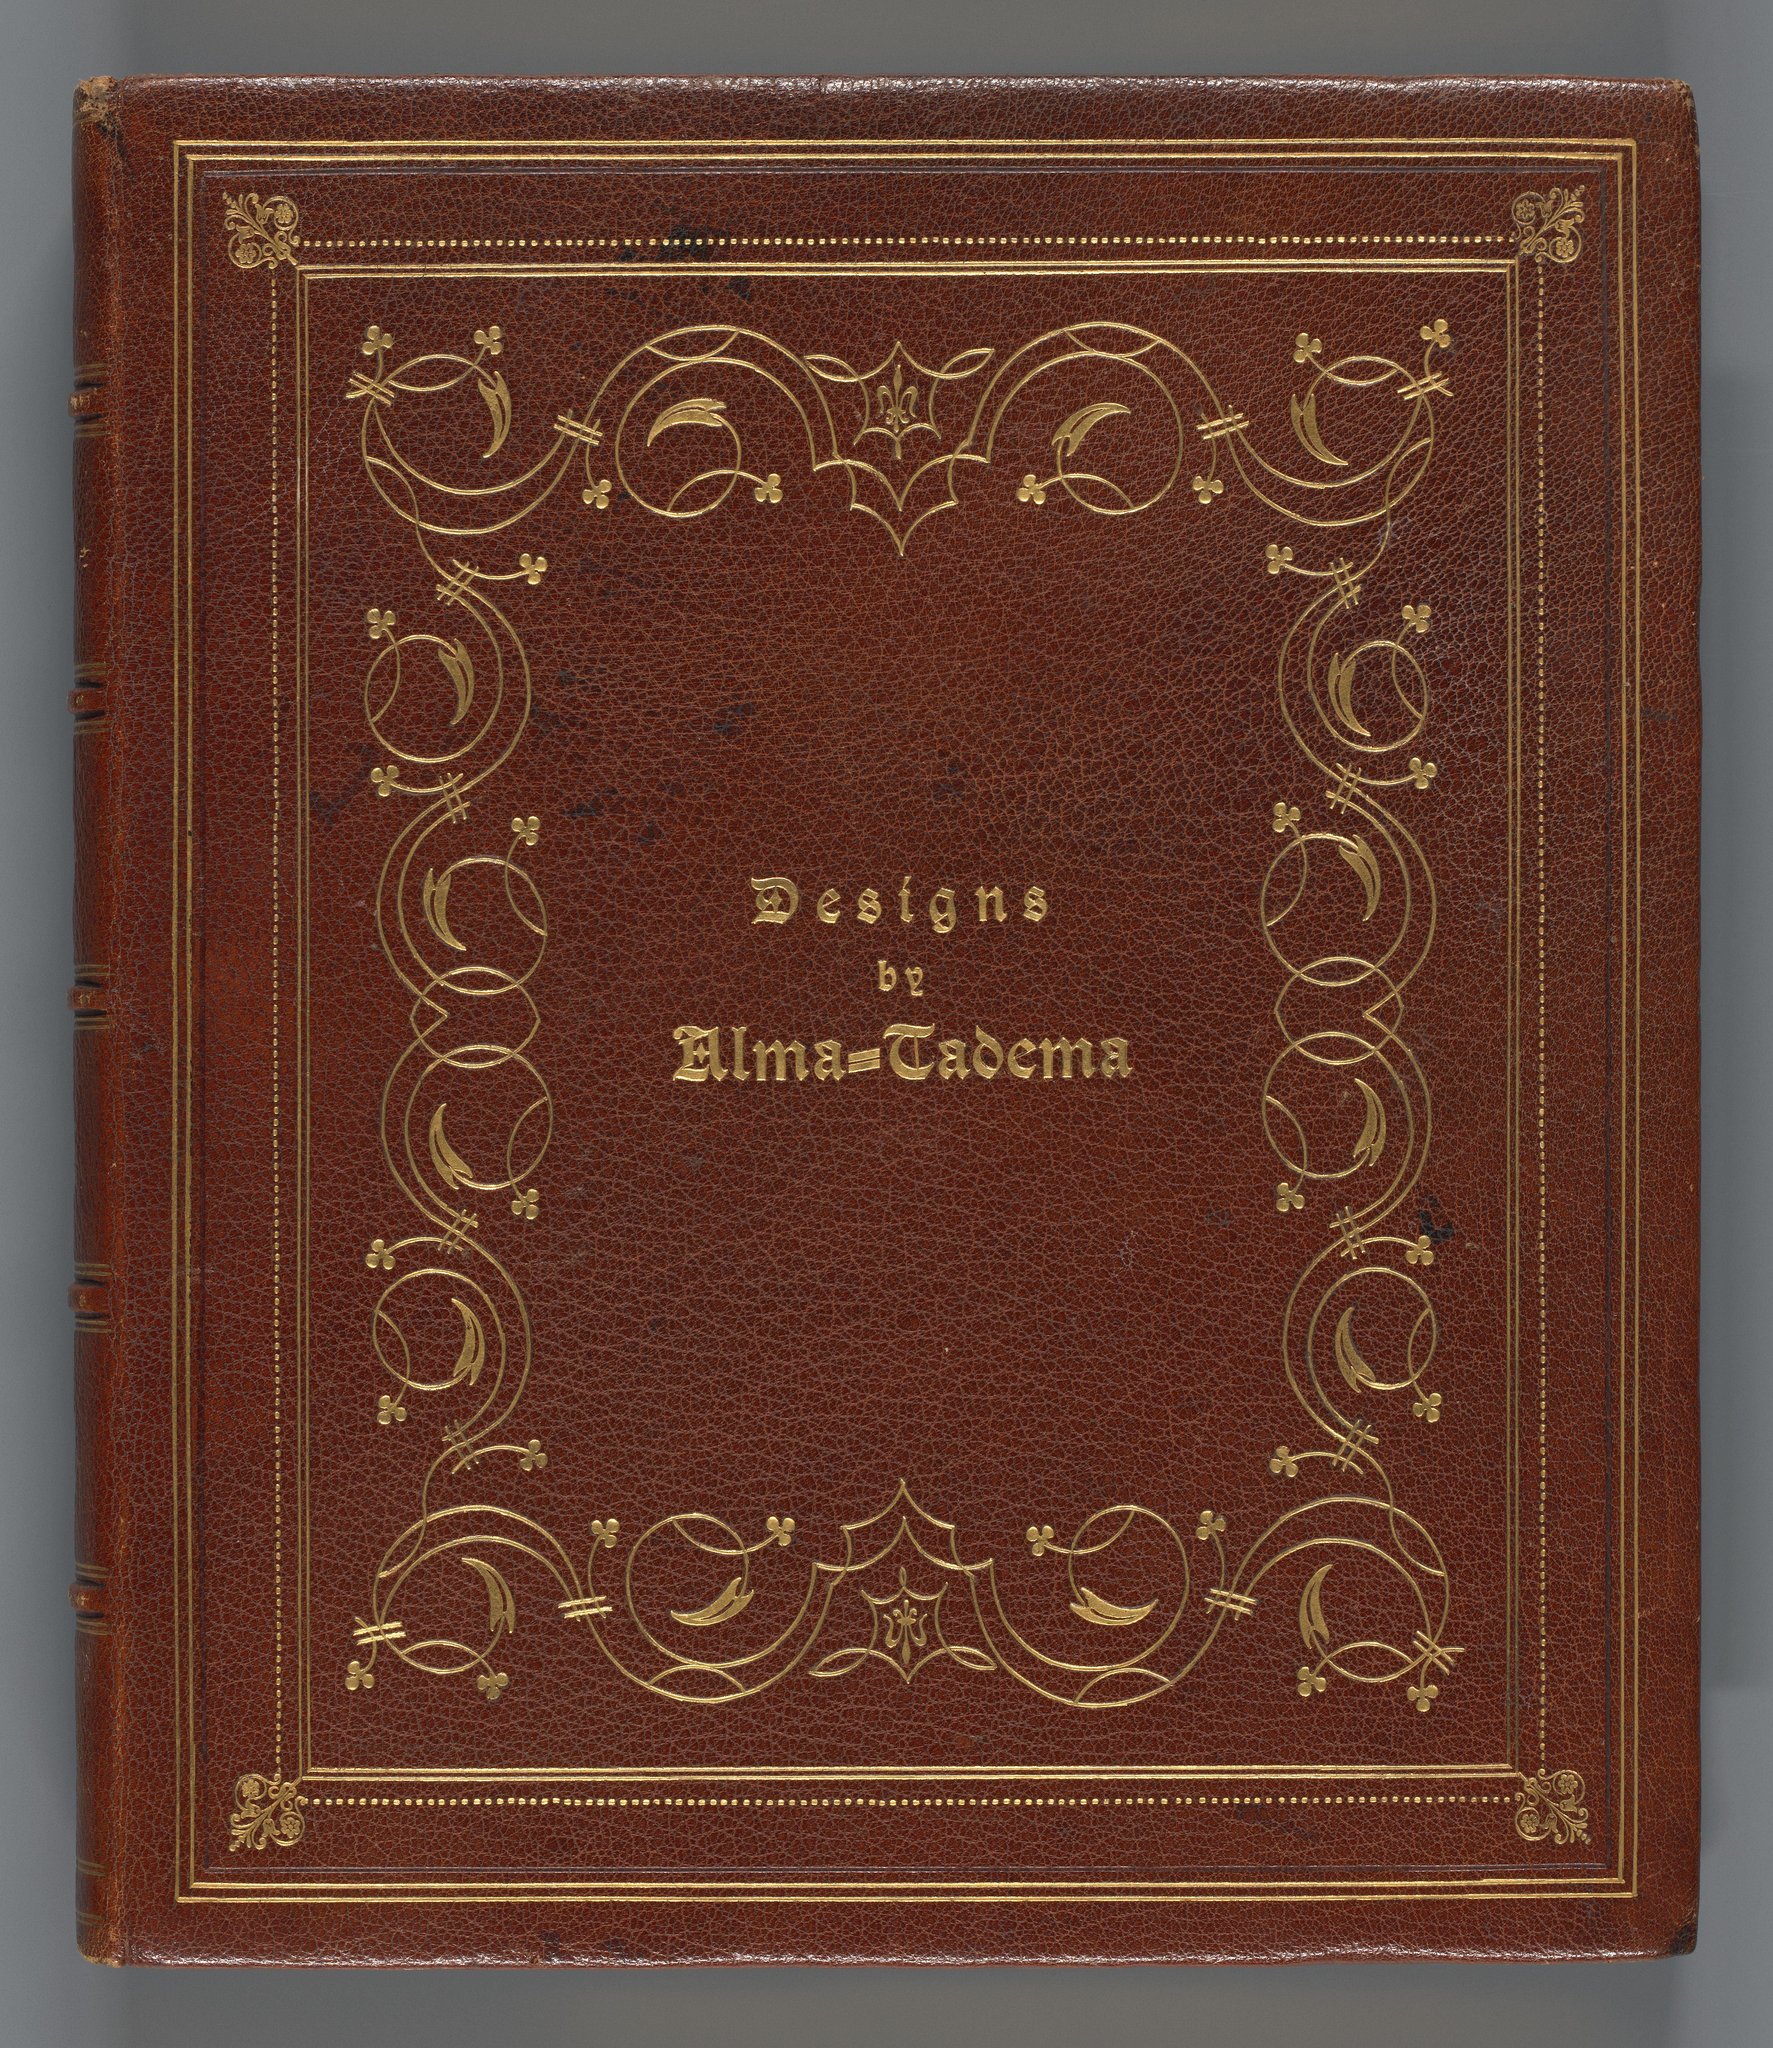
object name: album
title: Designs by Alma-Tadema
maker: anna alma tadema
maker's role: draughtsman, painter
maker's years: 1867-1943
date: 1880-1885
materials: paint, leather, paper, pencil, silk, watercolor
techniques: aquarelle, drawing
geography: london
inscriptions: signature: ‘AT’, inscription: ‘Anna’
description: Een album in bruin leer met gouden opdruk, dat 36 bladen bevat met ontwerpen voor een fotoalbum, ontworpen in potlood en geschilderd in aquarel. Het schutblad is van zijde.